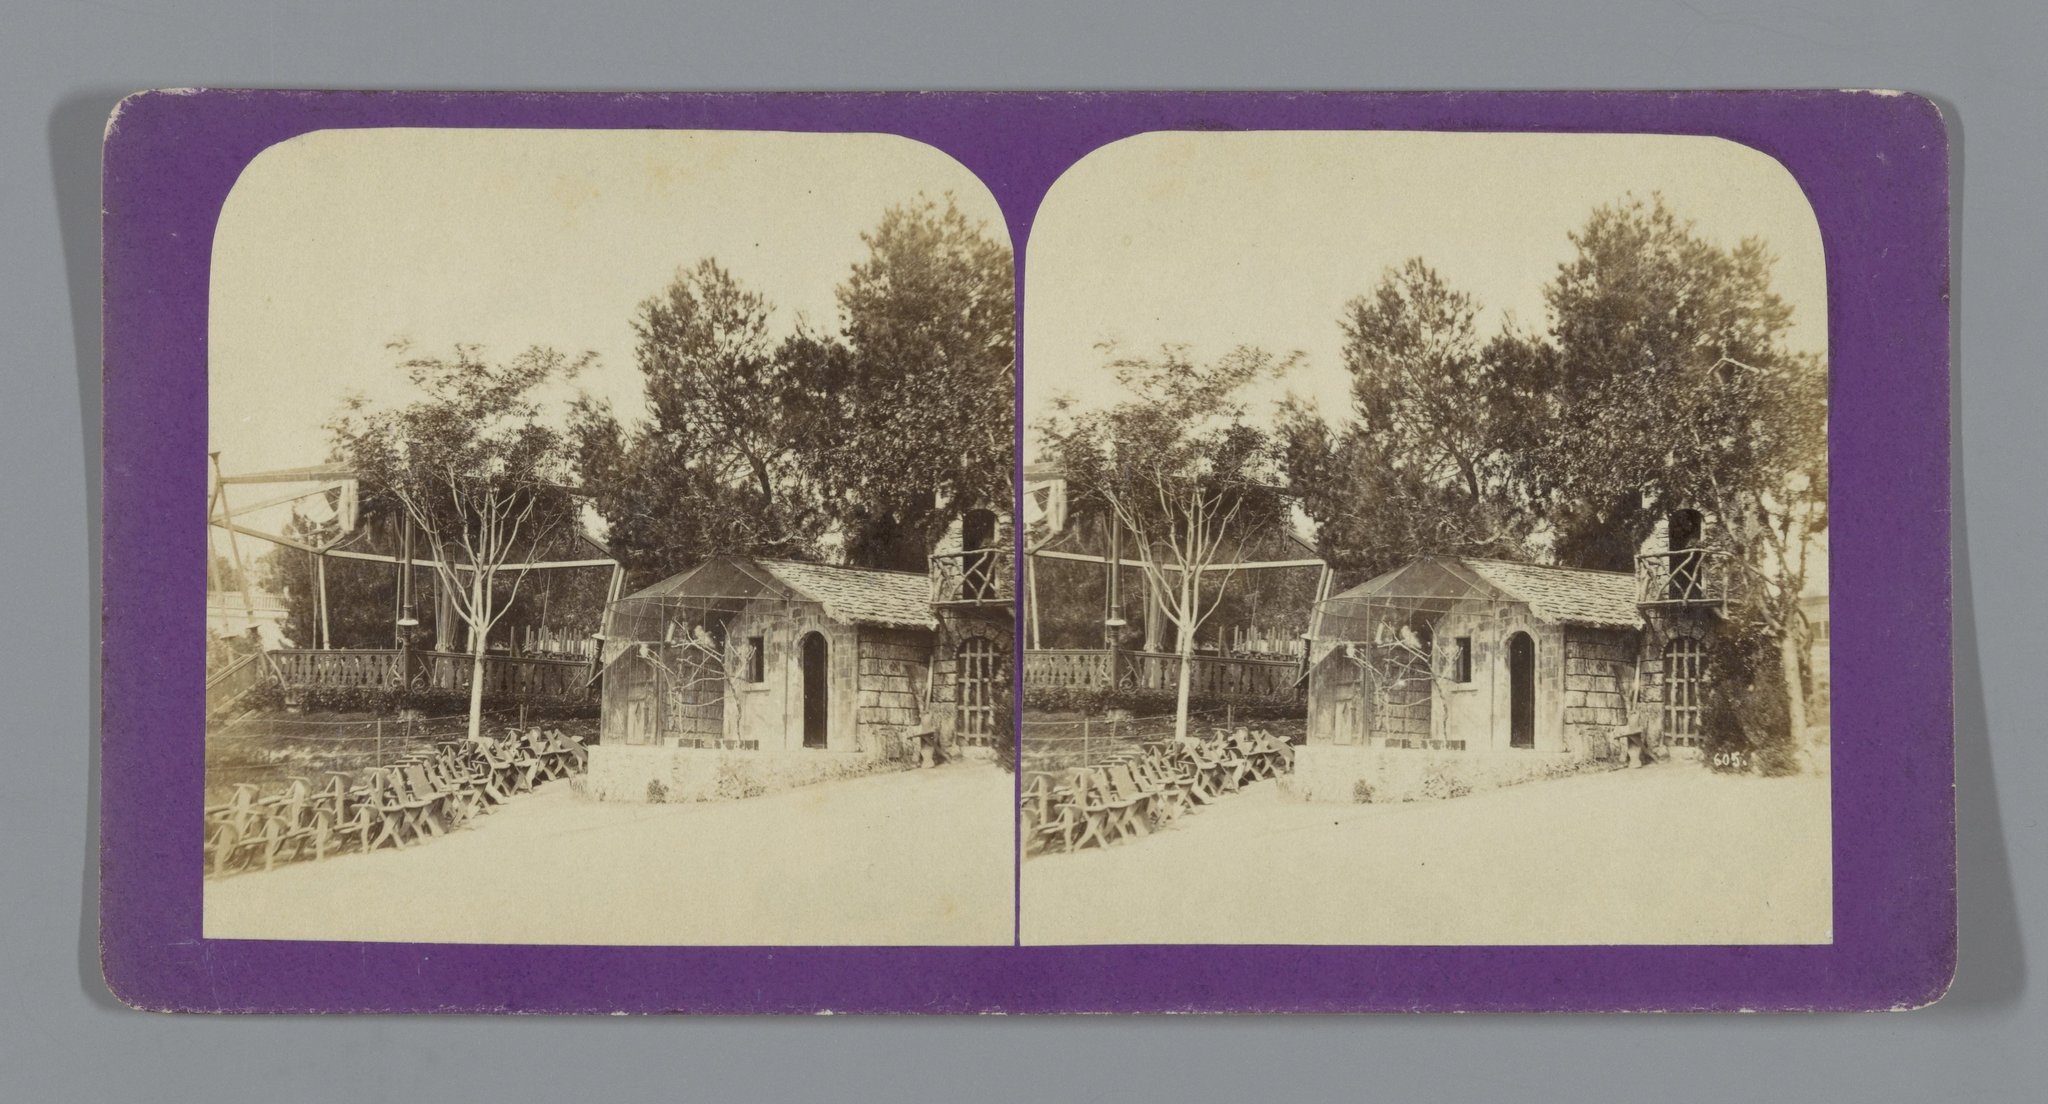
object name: stereograph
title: Gebouw in de dierentuin te Marseille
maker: jean andrieu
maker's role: fotograaf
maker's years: 1816-1872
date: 1862-1876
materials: cardboard, photographic support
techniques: albumen print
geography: marseille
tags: zoological garden, zoo, seen as place where non-domestic animals are kept, façade (of house or building)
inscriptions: inscription: ‘La tour en liege Jardin Zoologique Marseille’, number: ‘609’